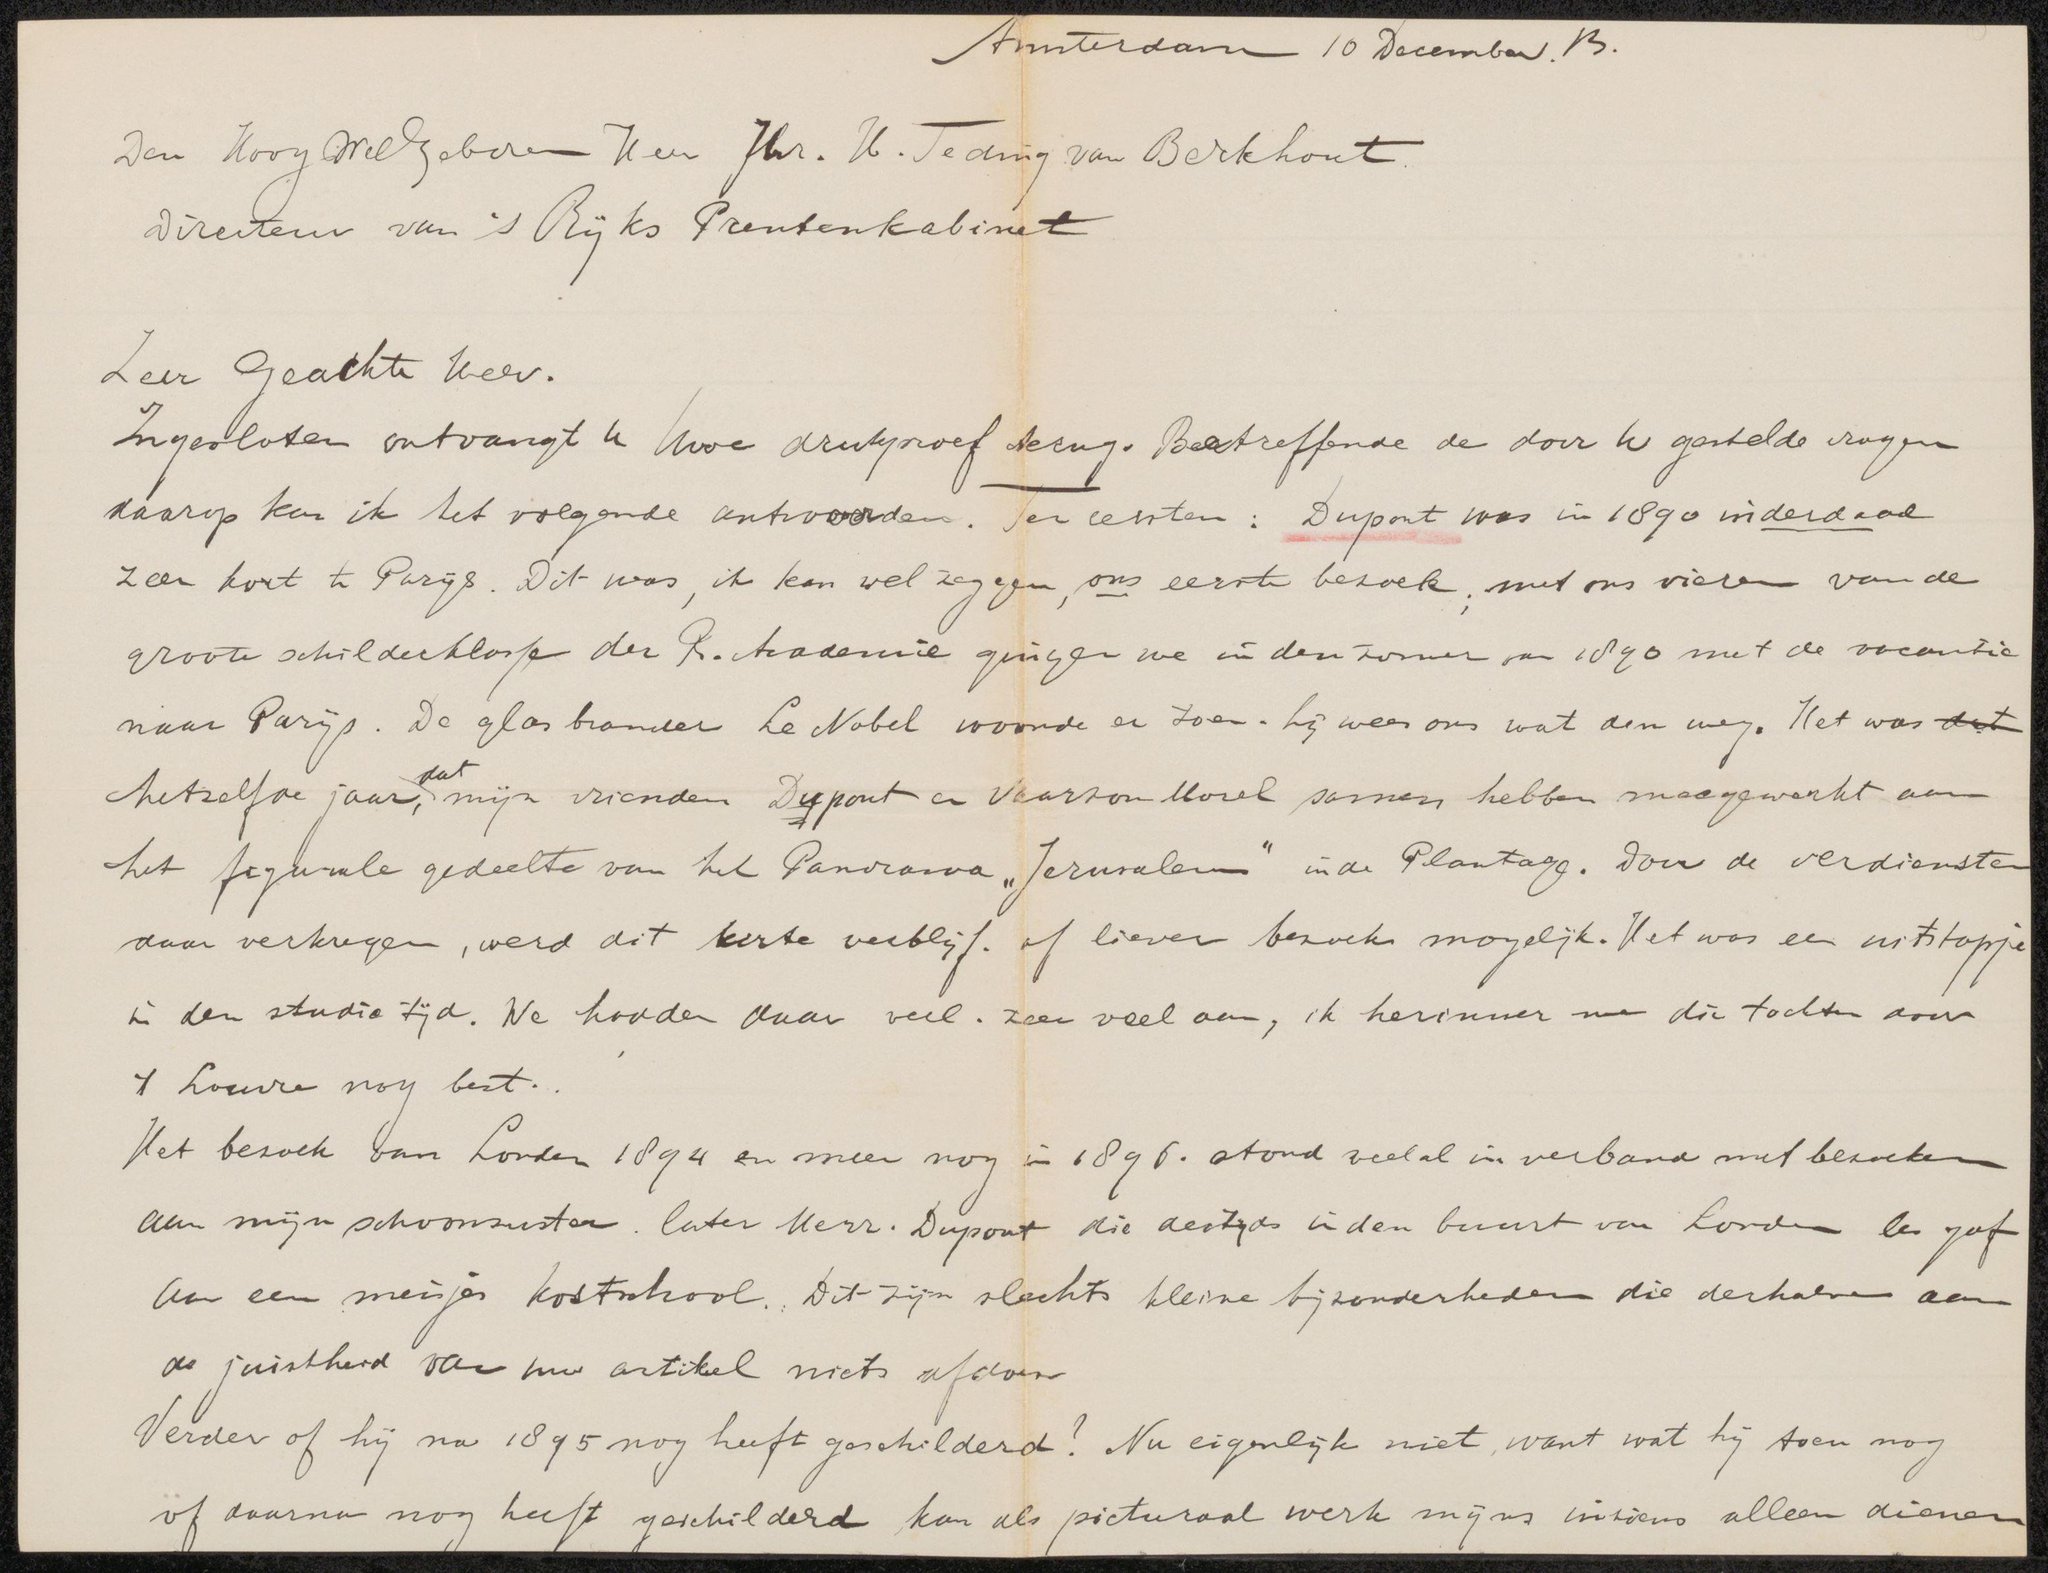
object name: letter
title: Brief aan jonkheer Hendrik Teding van Berkhout (1879-1969)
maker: klaas van leeuwen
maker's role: print maker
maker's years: 1867-1935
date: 1913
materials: ink, paper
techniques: pen, writing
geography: amsterdam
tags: print room, print maker, draughtsman, pieter dupont, haarlem, amsterdam, jonkheer hendrik teding van berkhout (1879-1969), the graphic arts, education, tuition of the artist (in general), painting (including book-illumination, miniature-painting), printed matter, london, paris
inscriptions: collector's mark: ‘RPK’